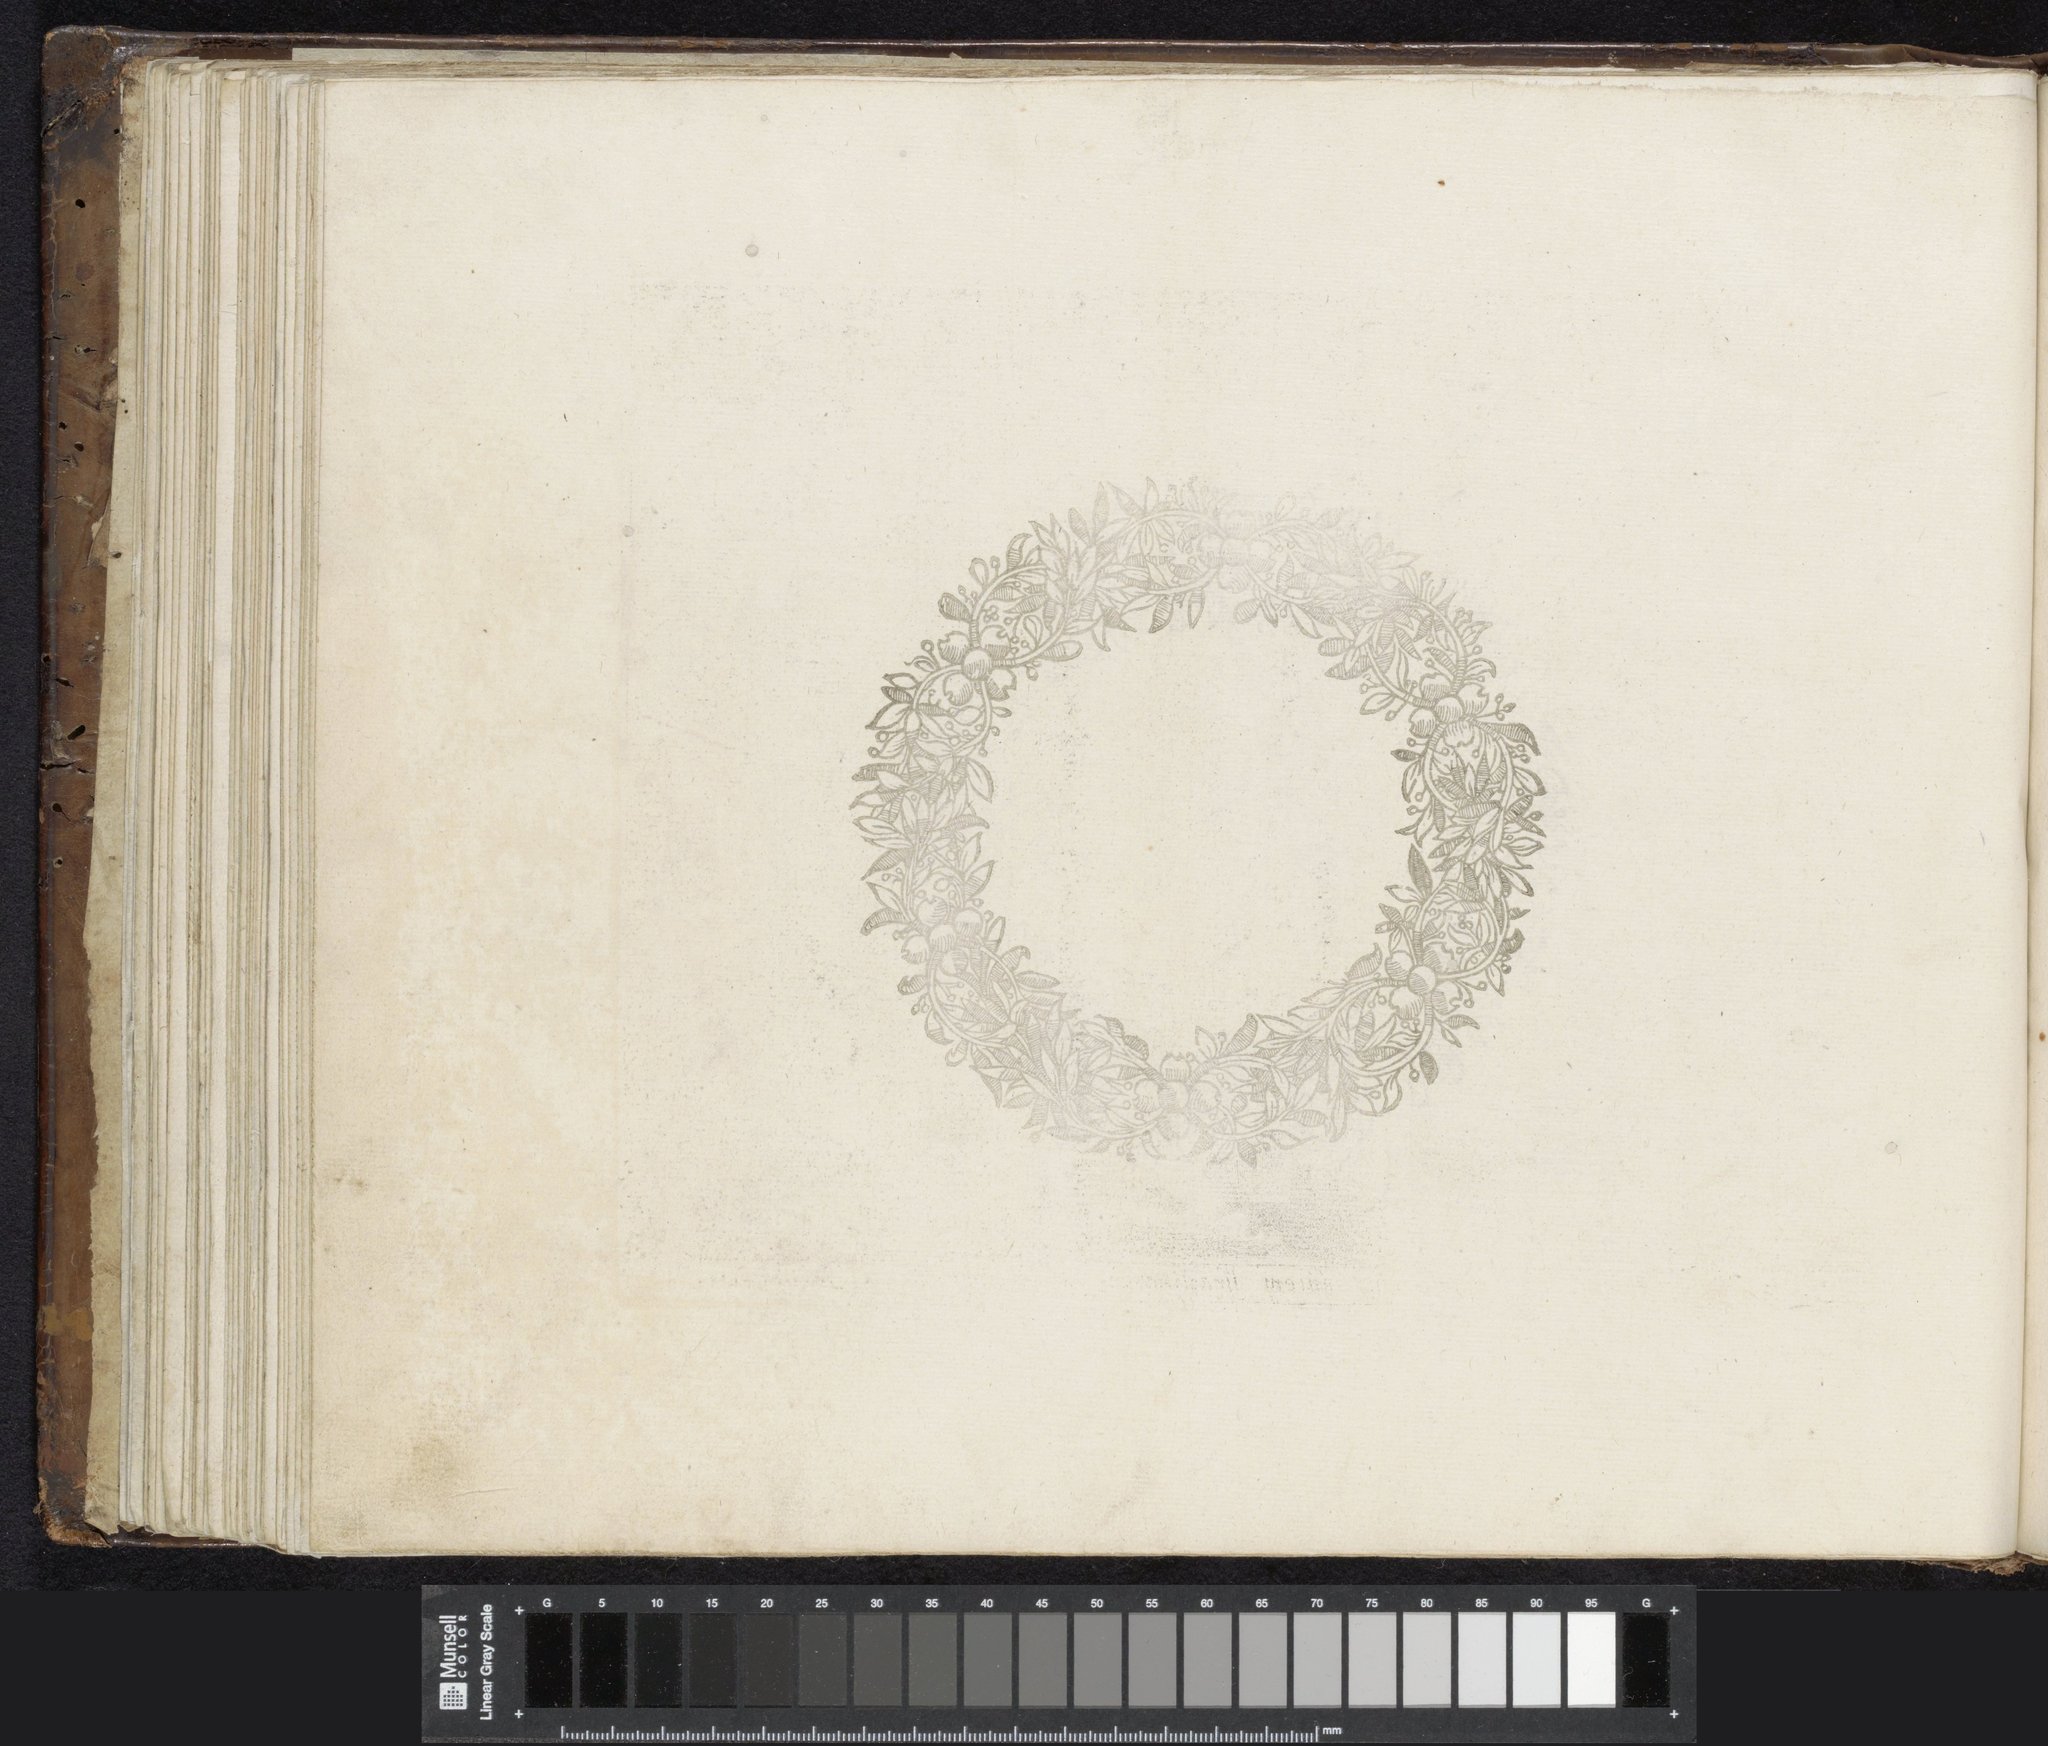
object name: album leaf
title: Ornamentele bloemenkrans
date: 1579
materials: paper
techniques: printmaking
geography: antwerp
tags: garland, wreath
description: Ornamentele bloemenkrans. Prent maakt deel uit van een album.